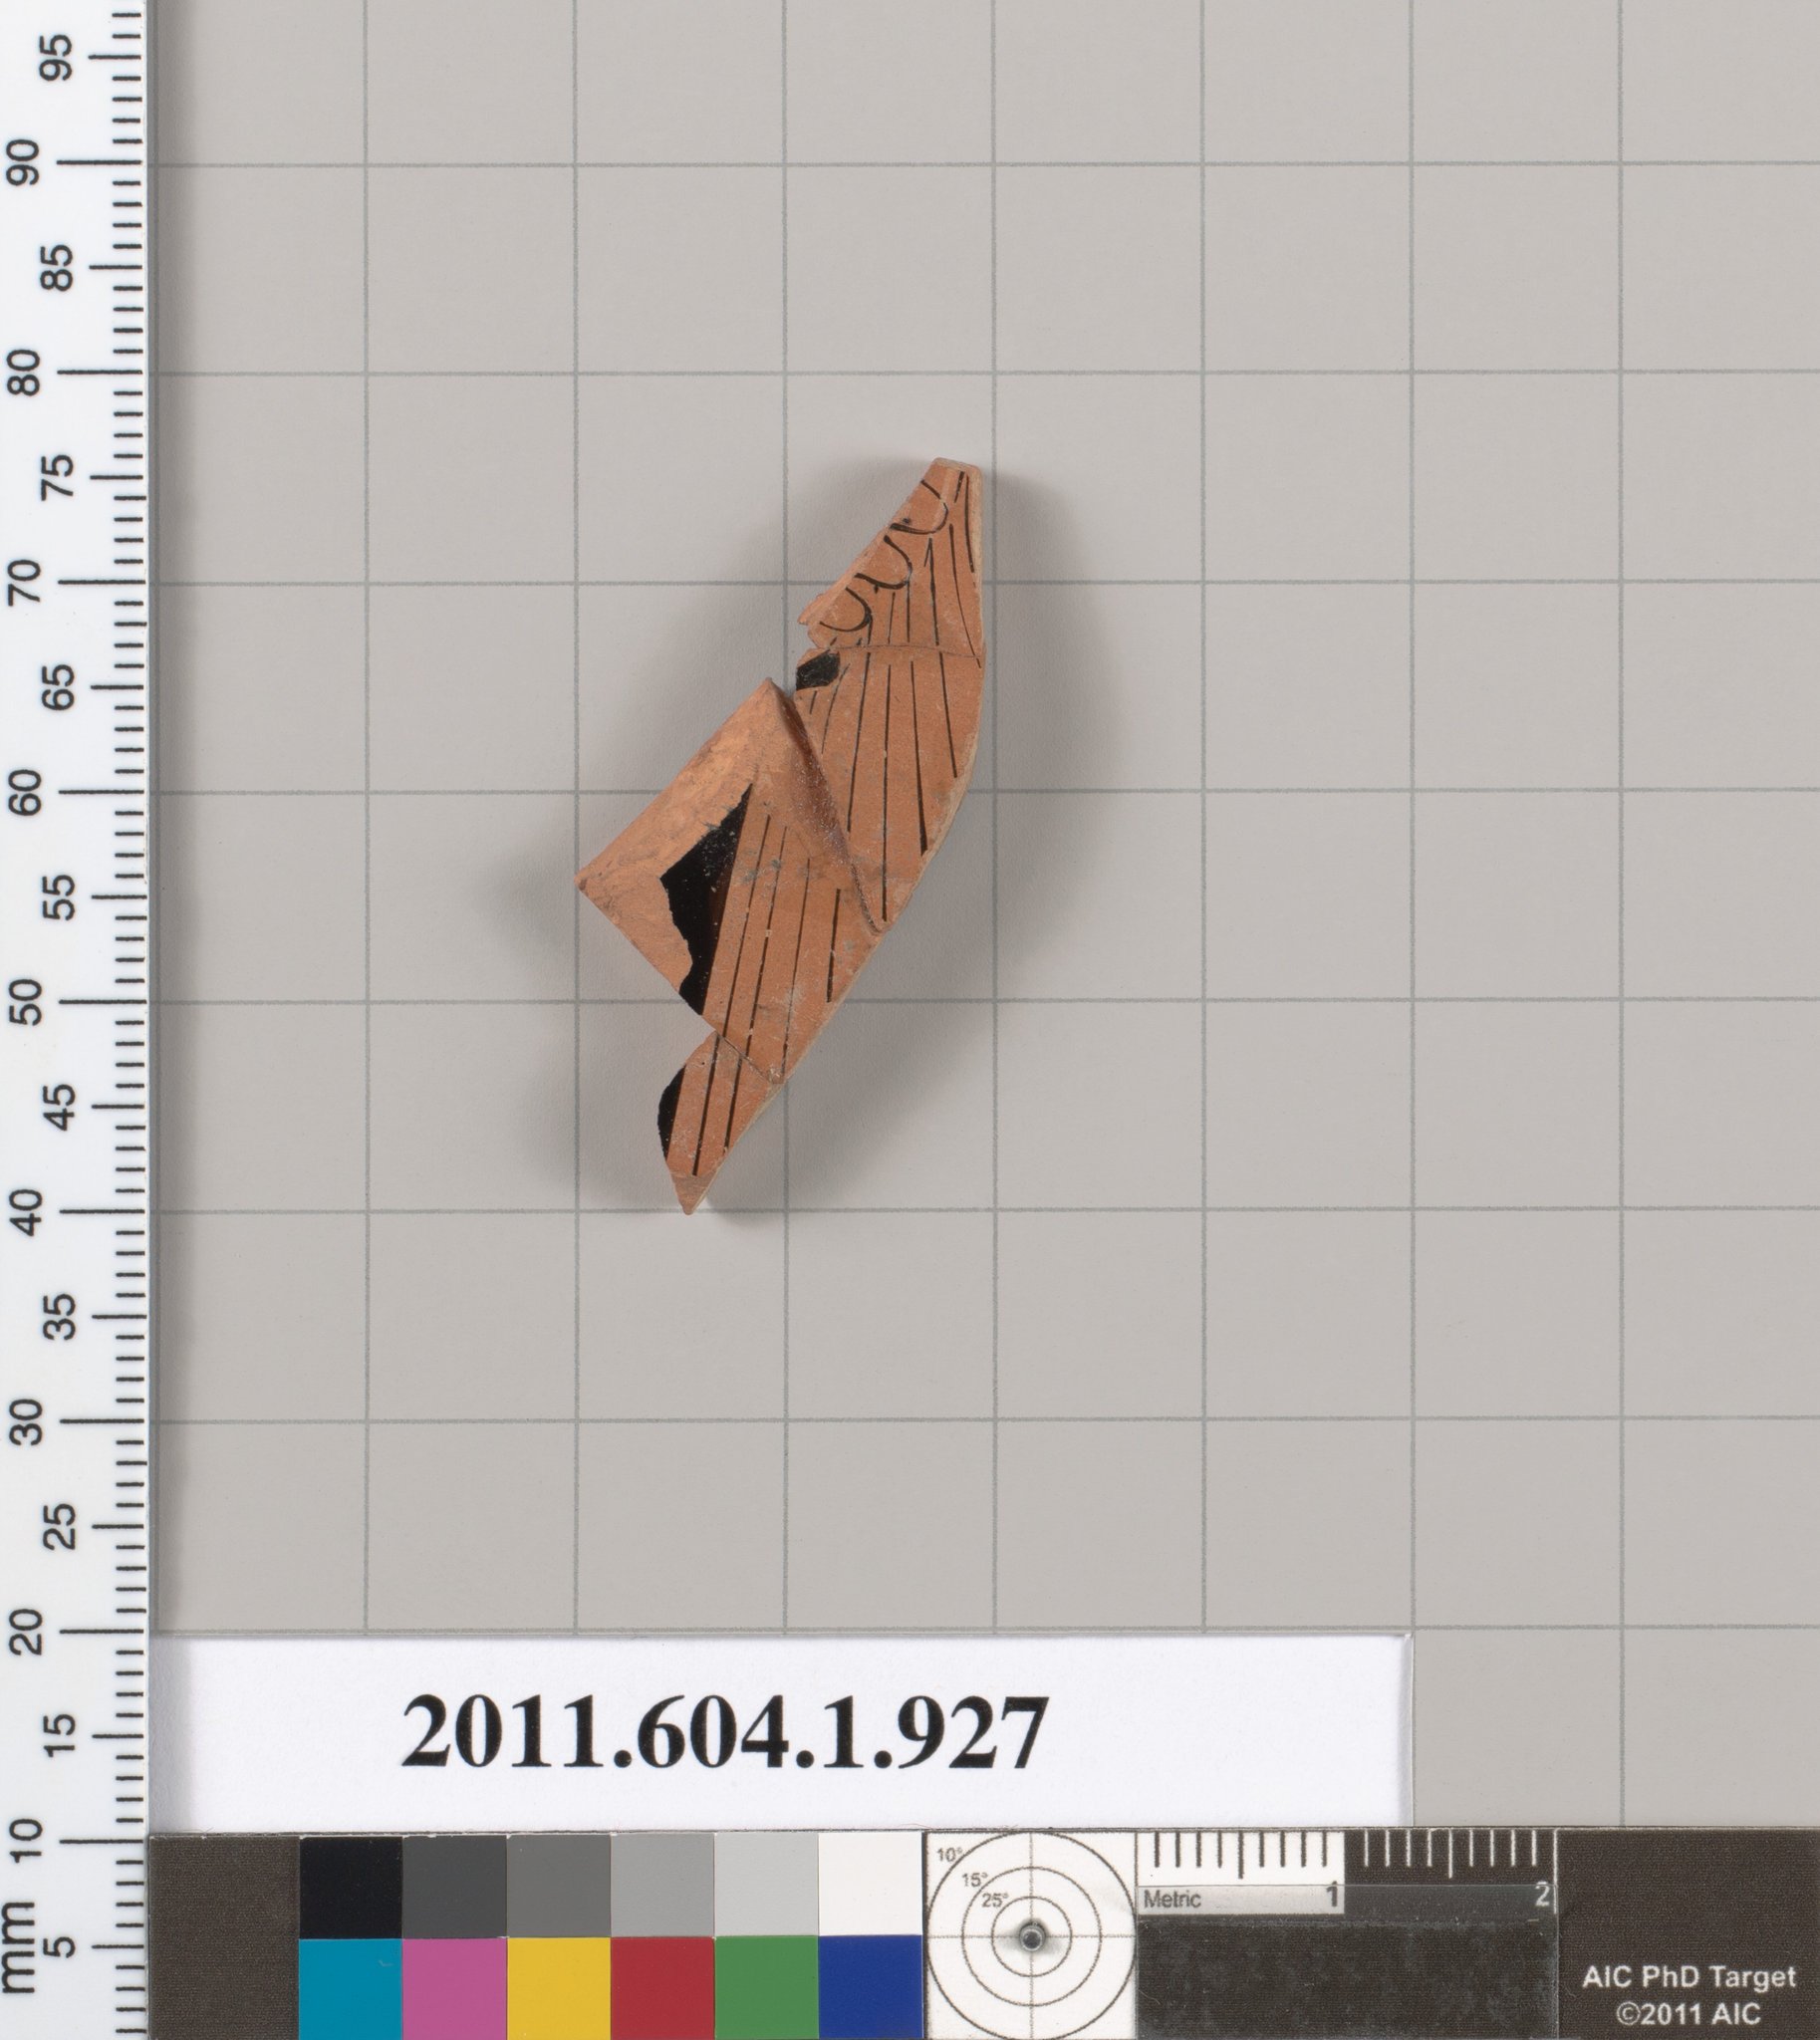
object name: kylix fragment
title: Terracotta fragment of a kylix (drinking cup)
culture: greek, attic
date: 490-480 BCE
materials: terracotta